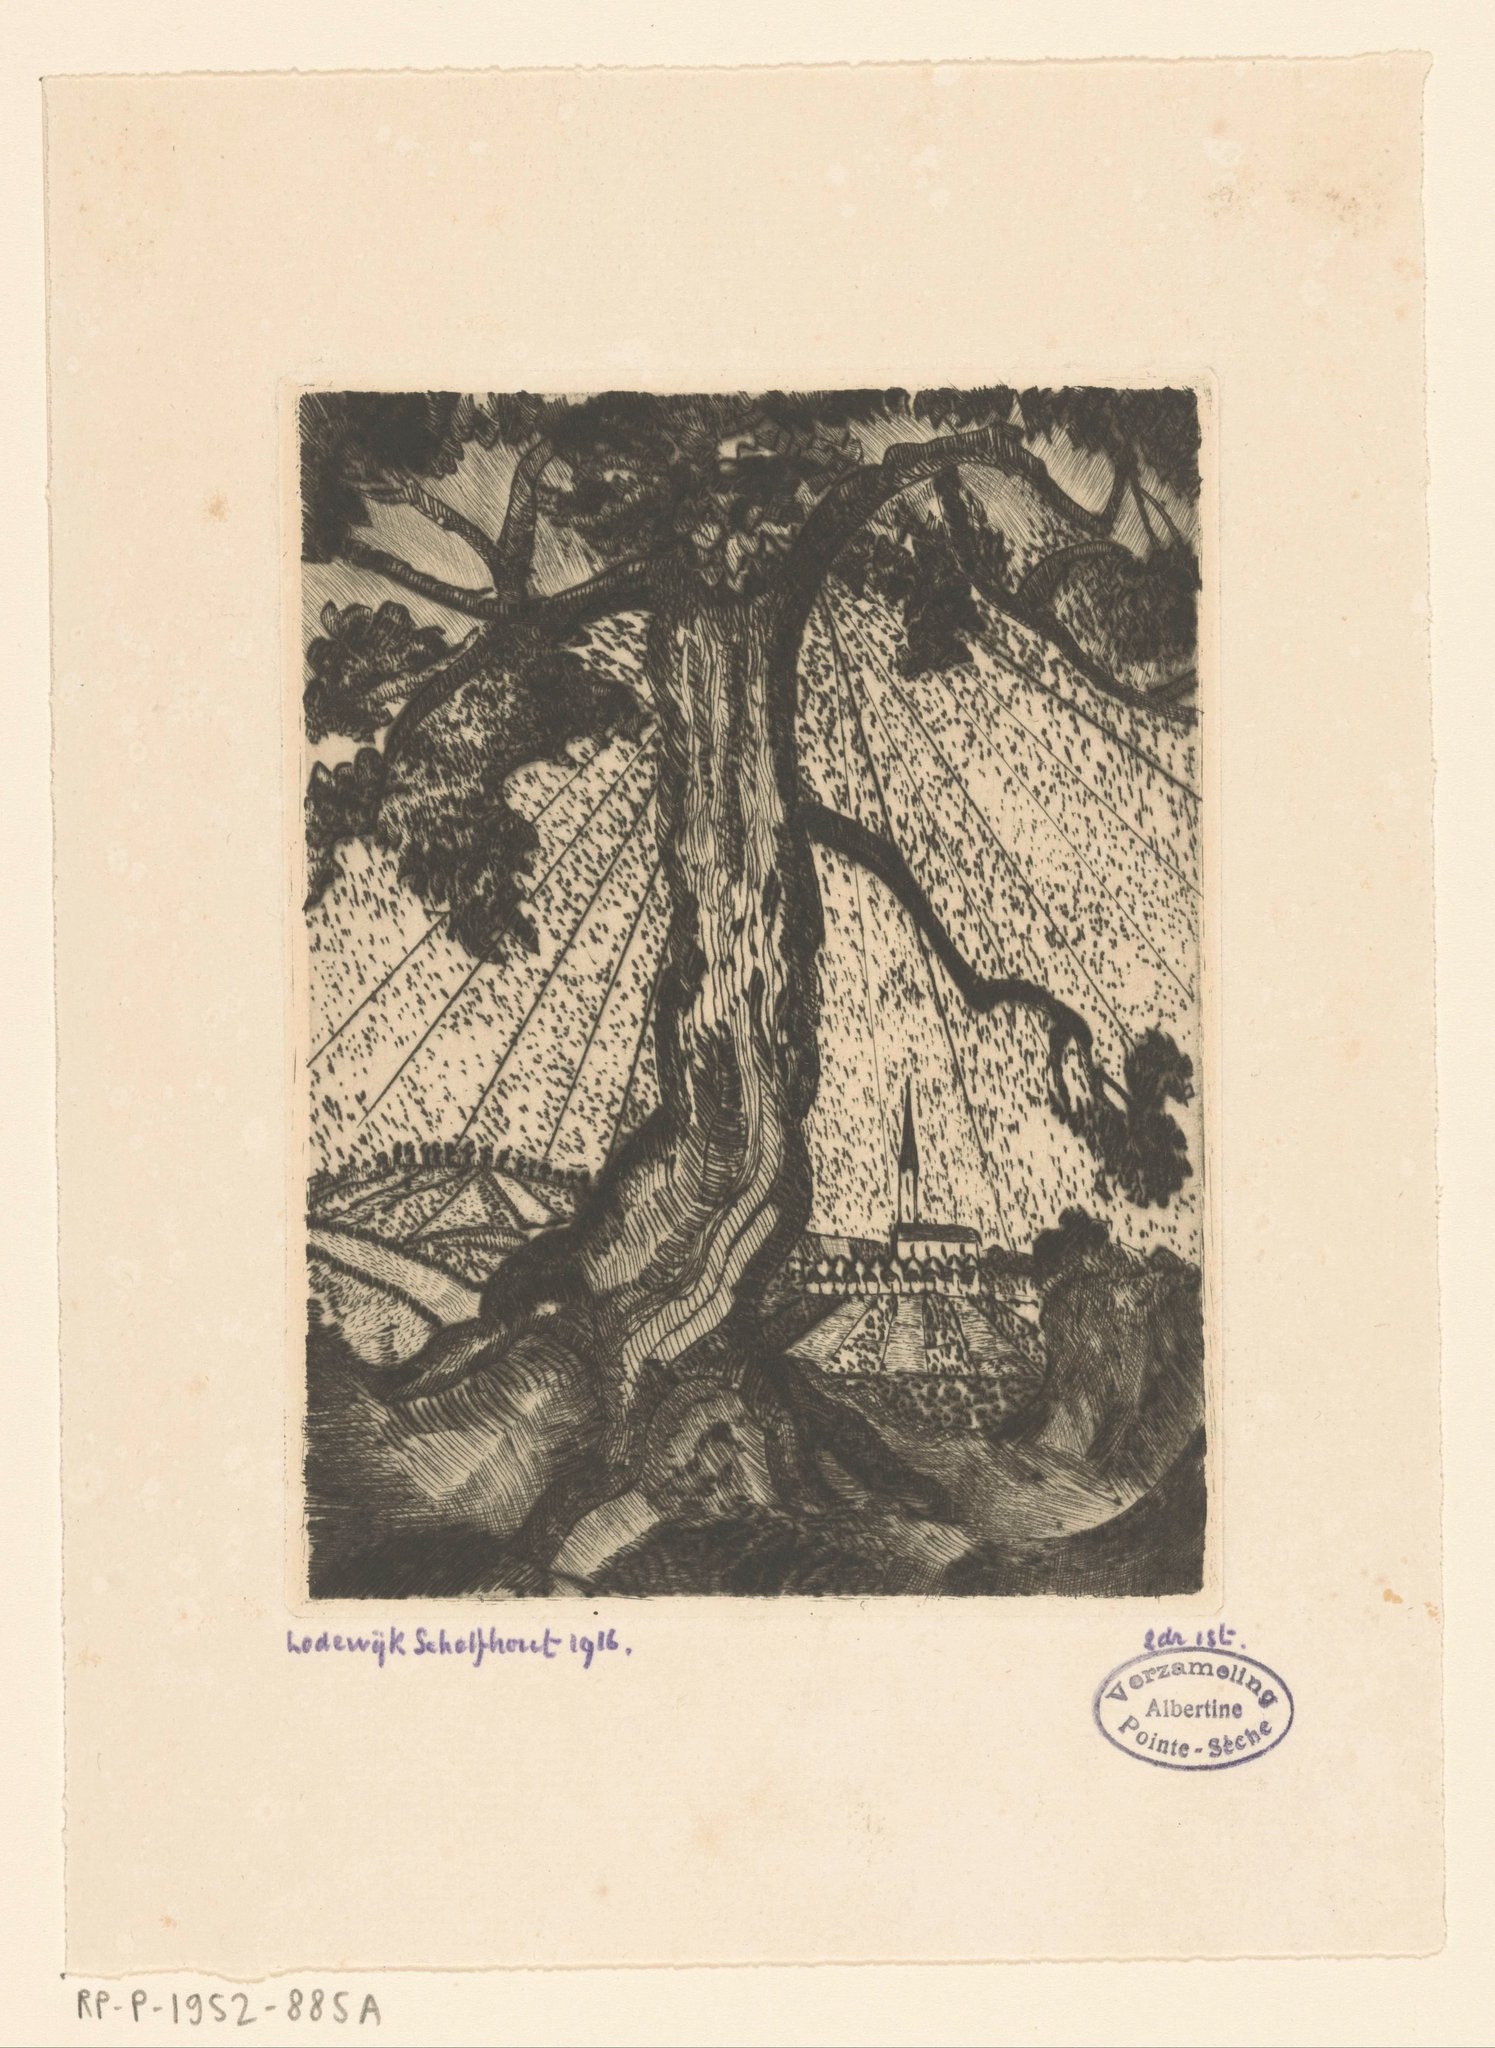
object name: print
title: Le Village I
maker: lodewijk schelfhout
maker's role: draughtsman, print maker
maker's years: 1881-1943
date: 1916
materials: paper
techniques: drypoint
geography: netherlands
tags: prospect of village, silhouette of village, trees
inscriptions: collector's mark: Lugt 5i, collector's mark: Lugt 2228, collector's mark: Lugt 2760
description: Een heuvellandschap met een boom, akkers en een nederzetting met kerk.